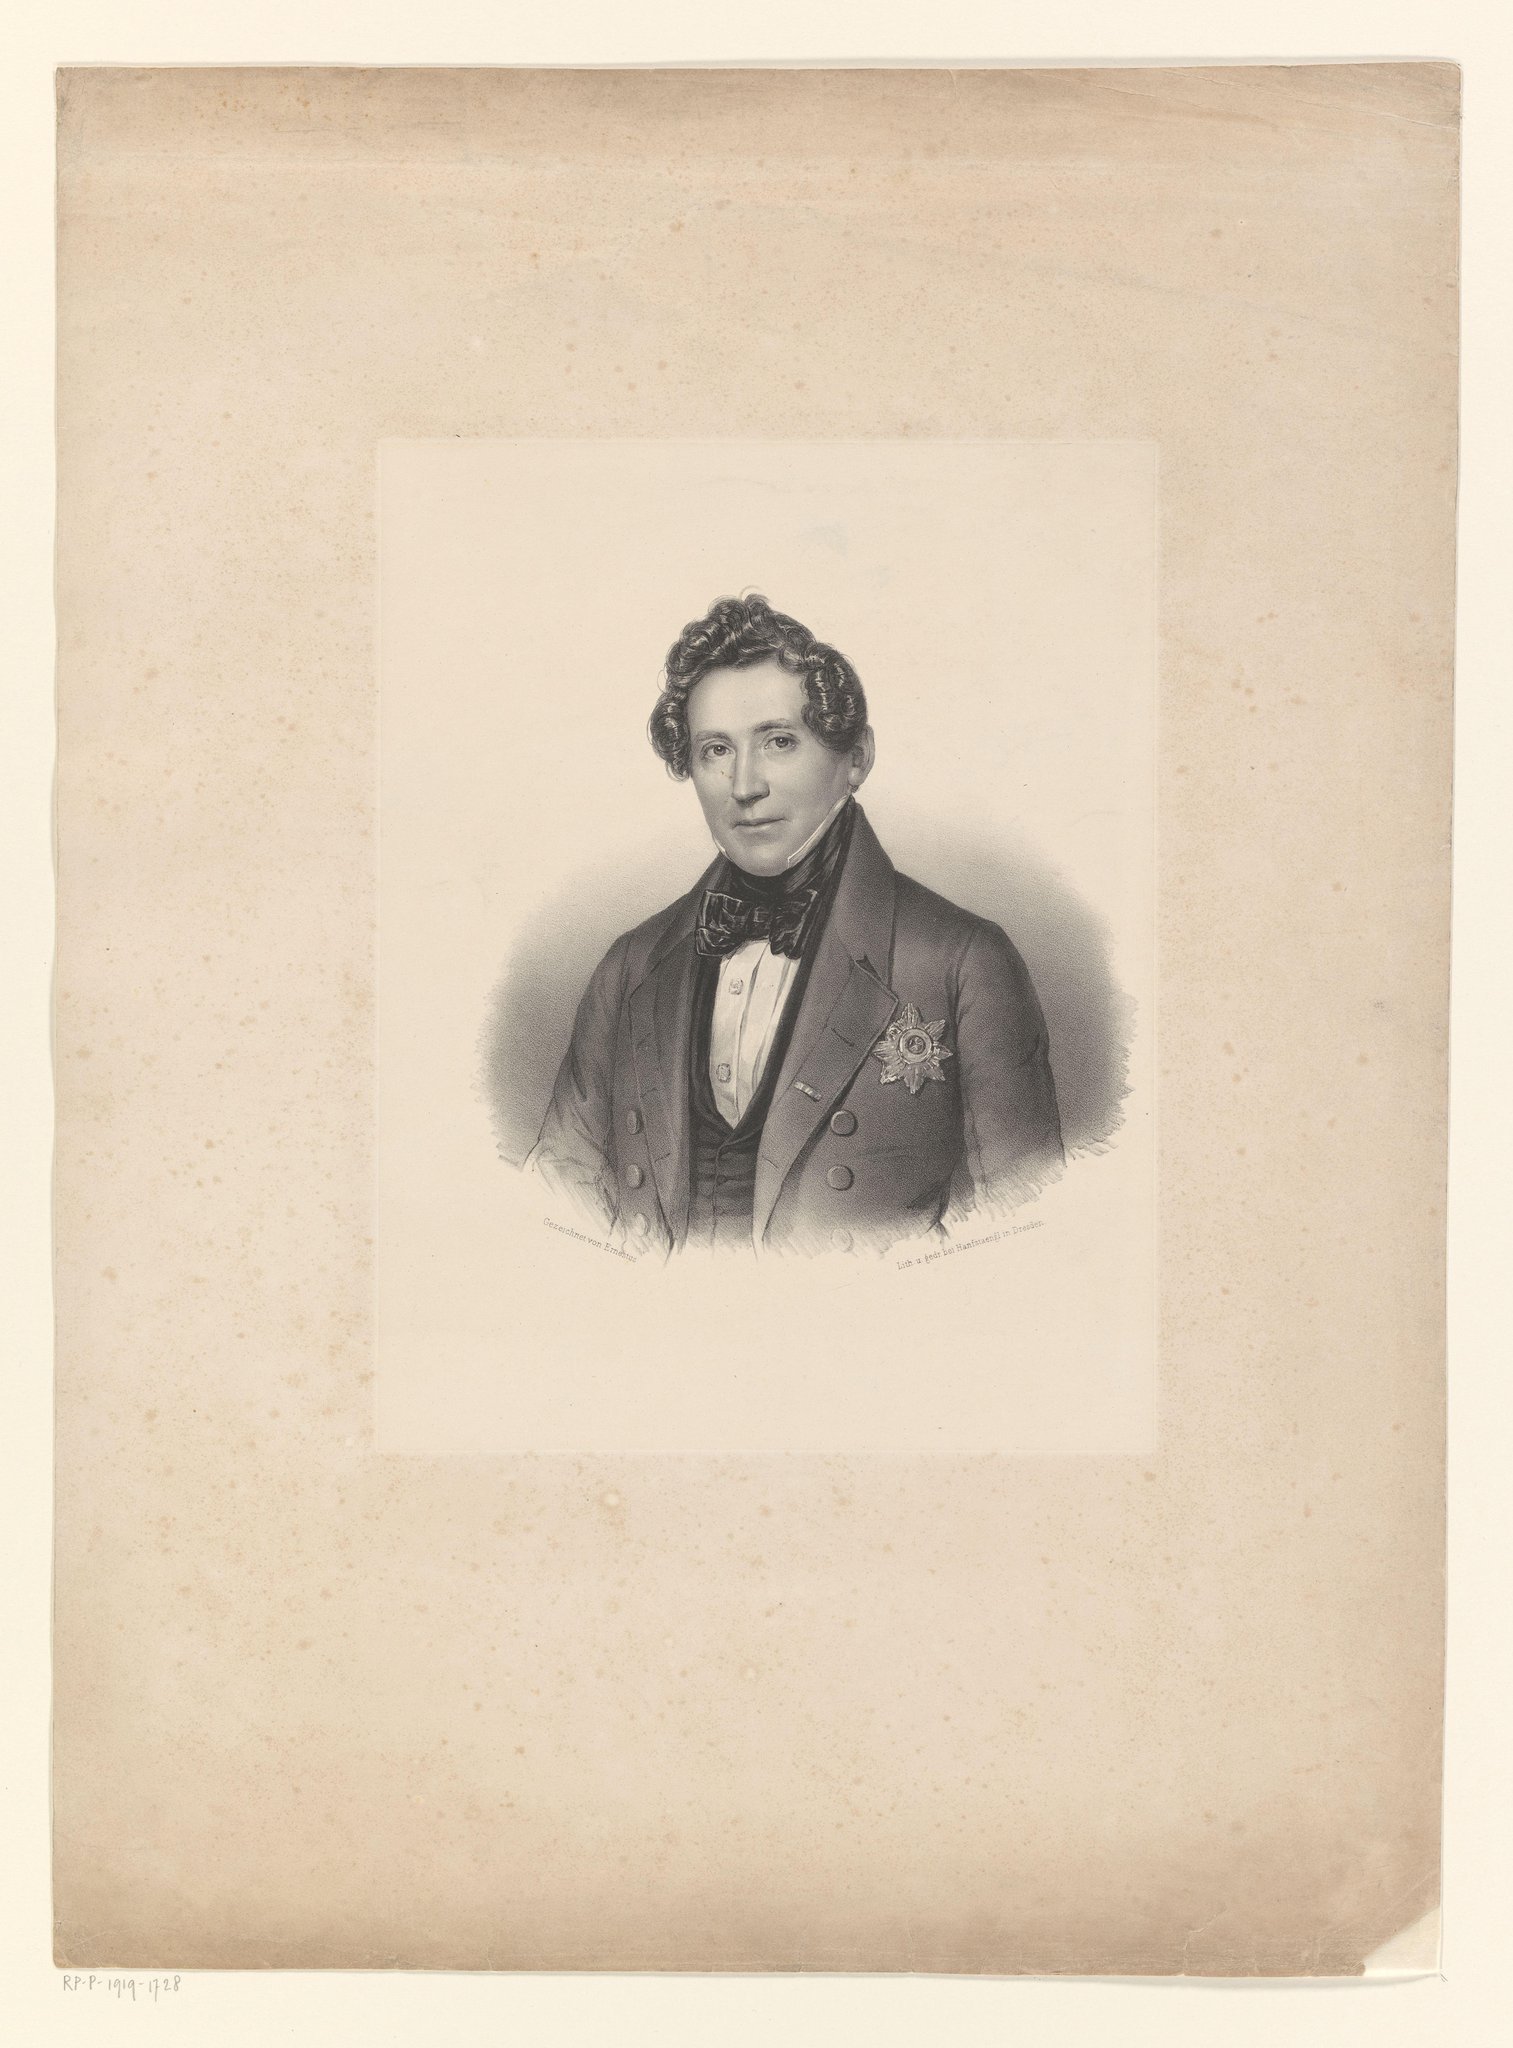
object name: print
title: Portret van een onbekende man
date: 1814-1877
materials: paper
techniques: lithograph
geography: dresden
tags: adult man, historical persons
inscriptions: collector's mark: Lugt 2228